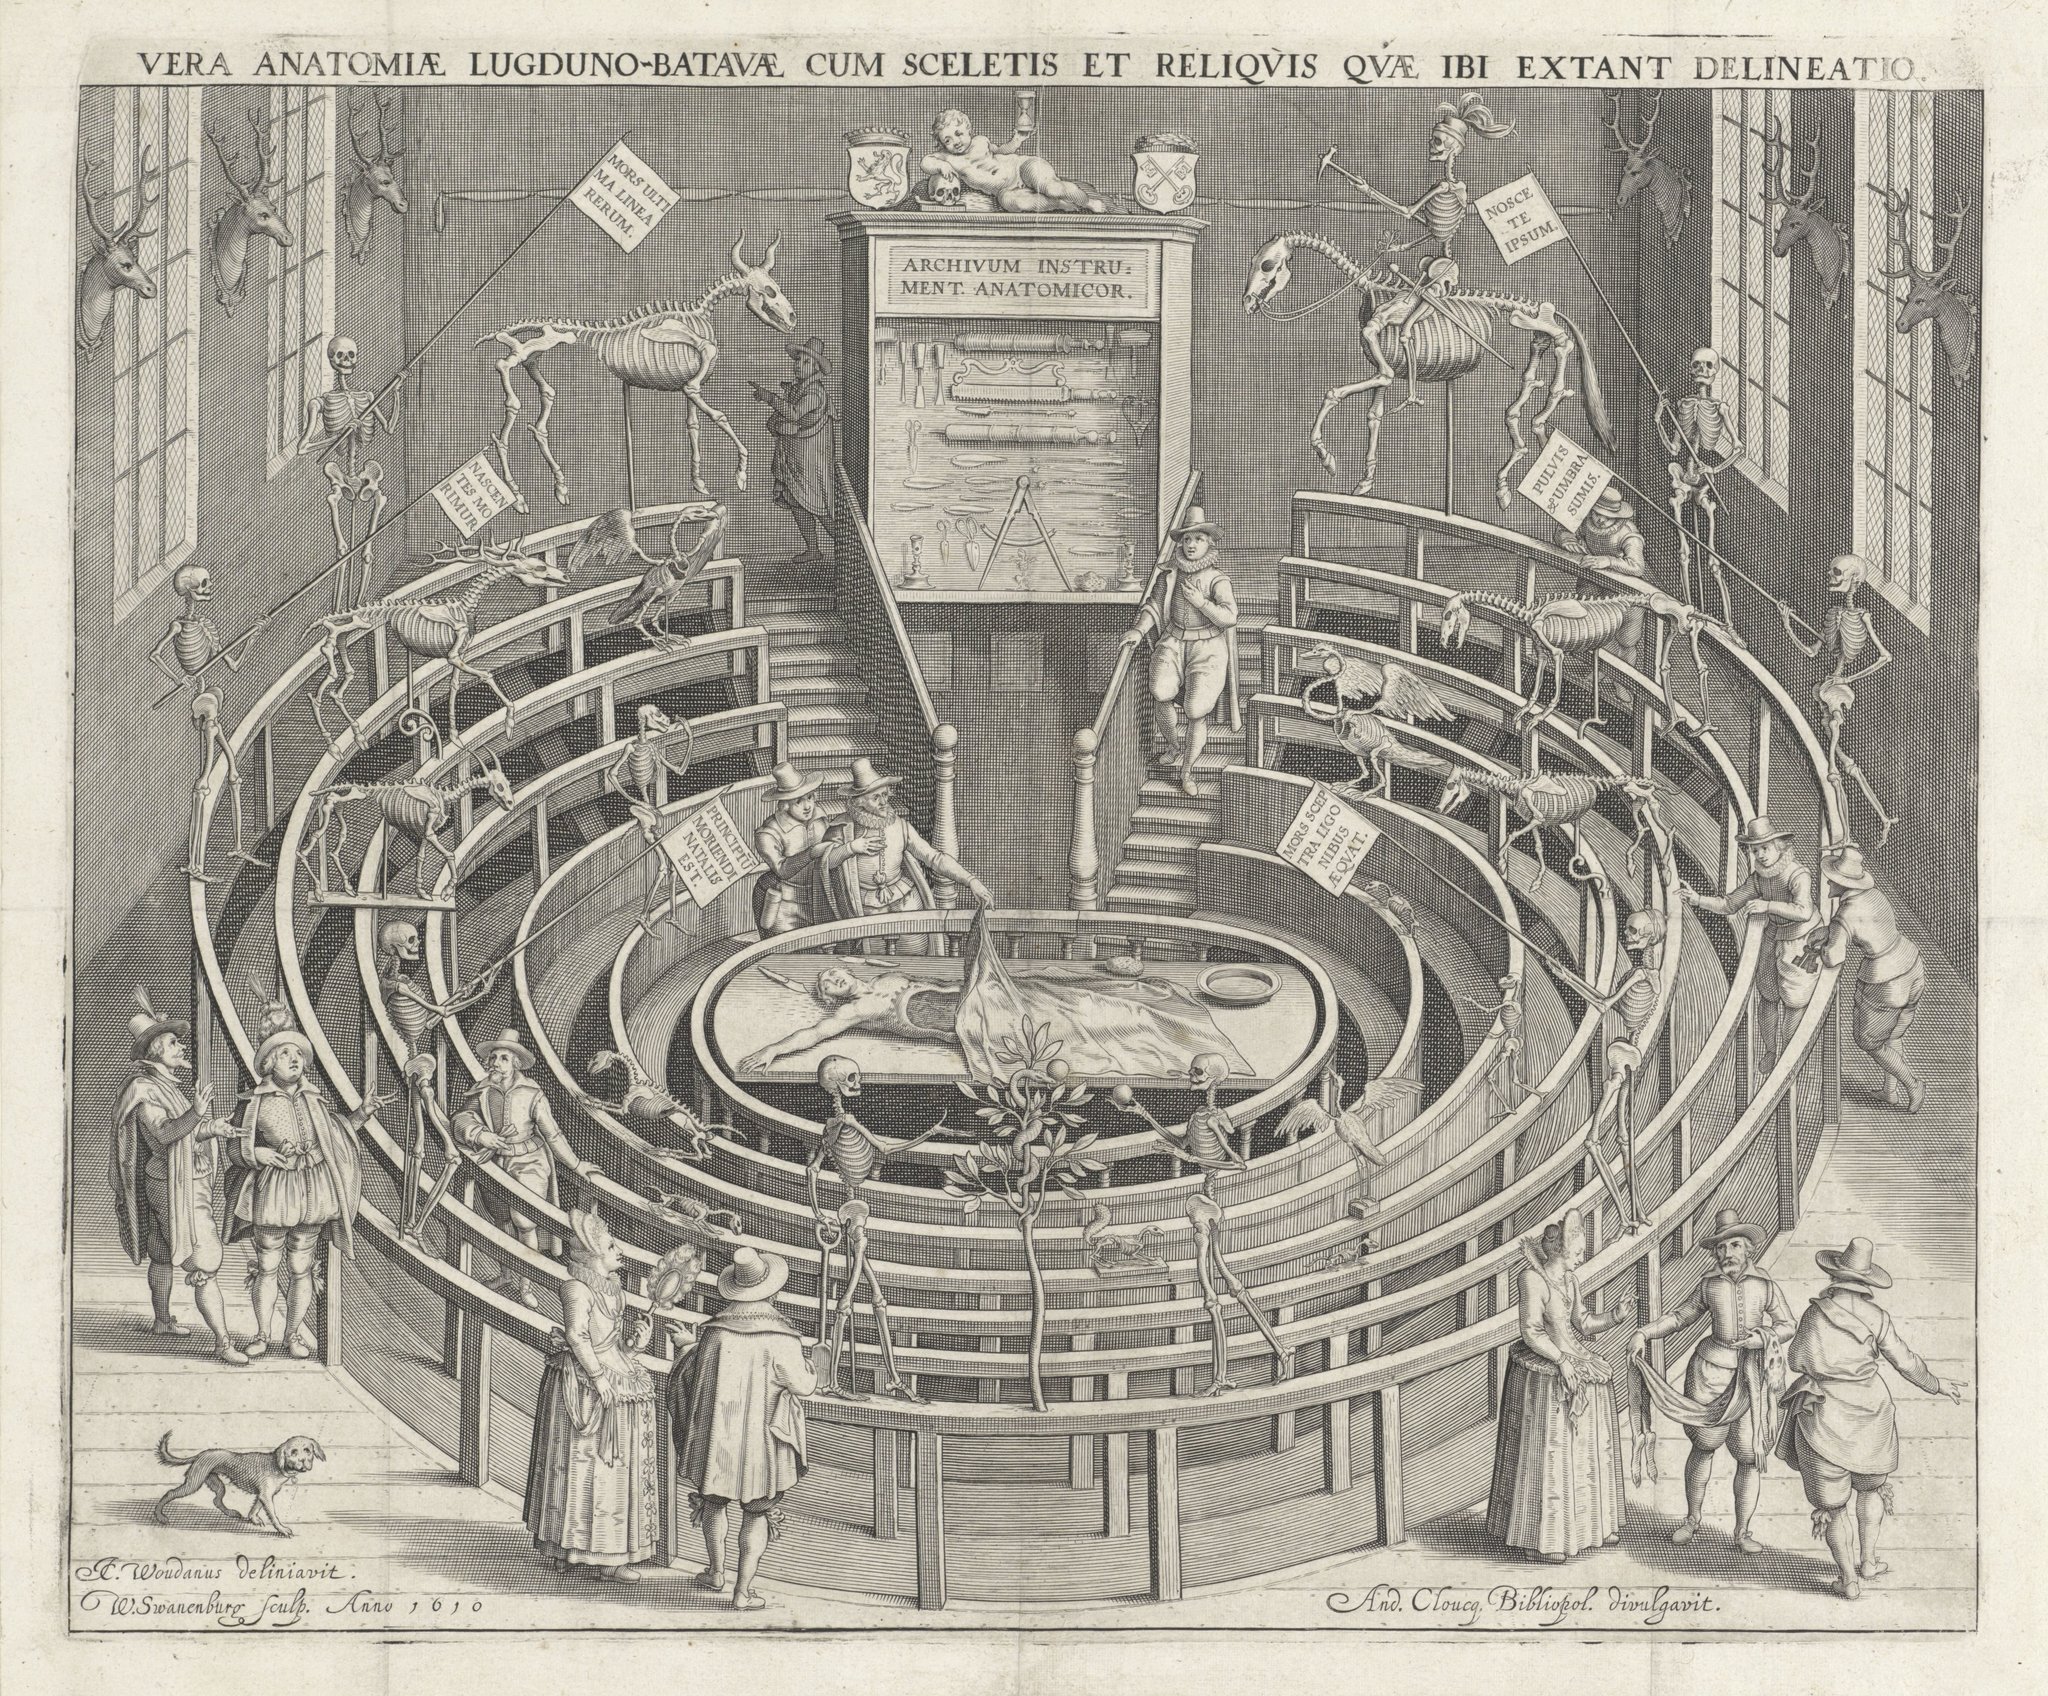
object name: print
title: Vera anatomiae Lugduno-Batavae cum sceletis et reliquis quae ibi extant delineatio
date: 1610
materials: paper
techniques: engraving, etching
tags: university, anatomy lesson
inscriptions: collector's mark: Lugt 2228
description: Anatomisch theater van de Universiteit van Leiden. Bij de anatomische les zijn verschillende toeschouwers aanwezig. In de ruimte hangen skeletten van mensen en dieren. Onderdeel van een groep van vier gezichten van de Universiteit van Leiden, later gebruikt als illustratie in het supplement van het boek van Meursius over de Leidse universiteit.